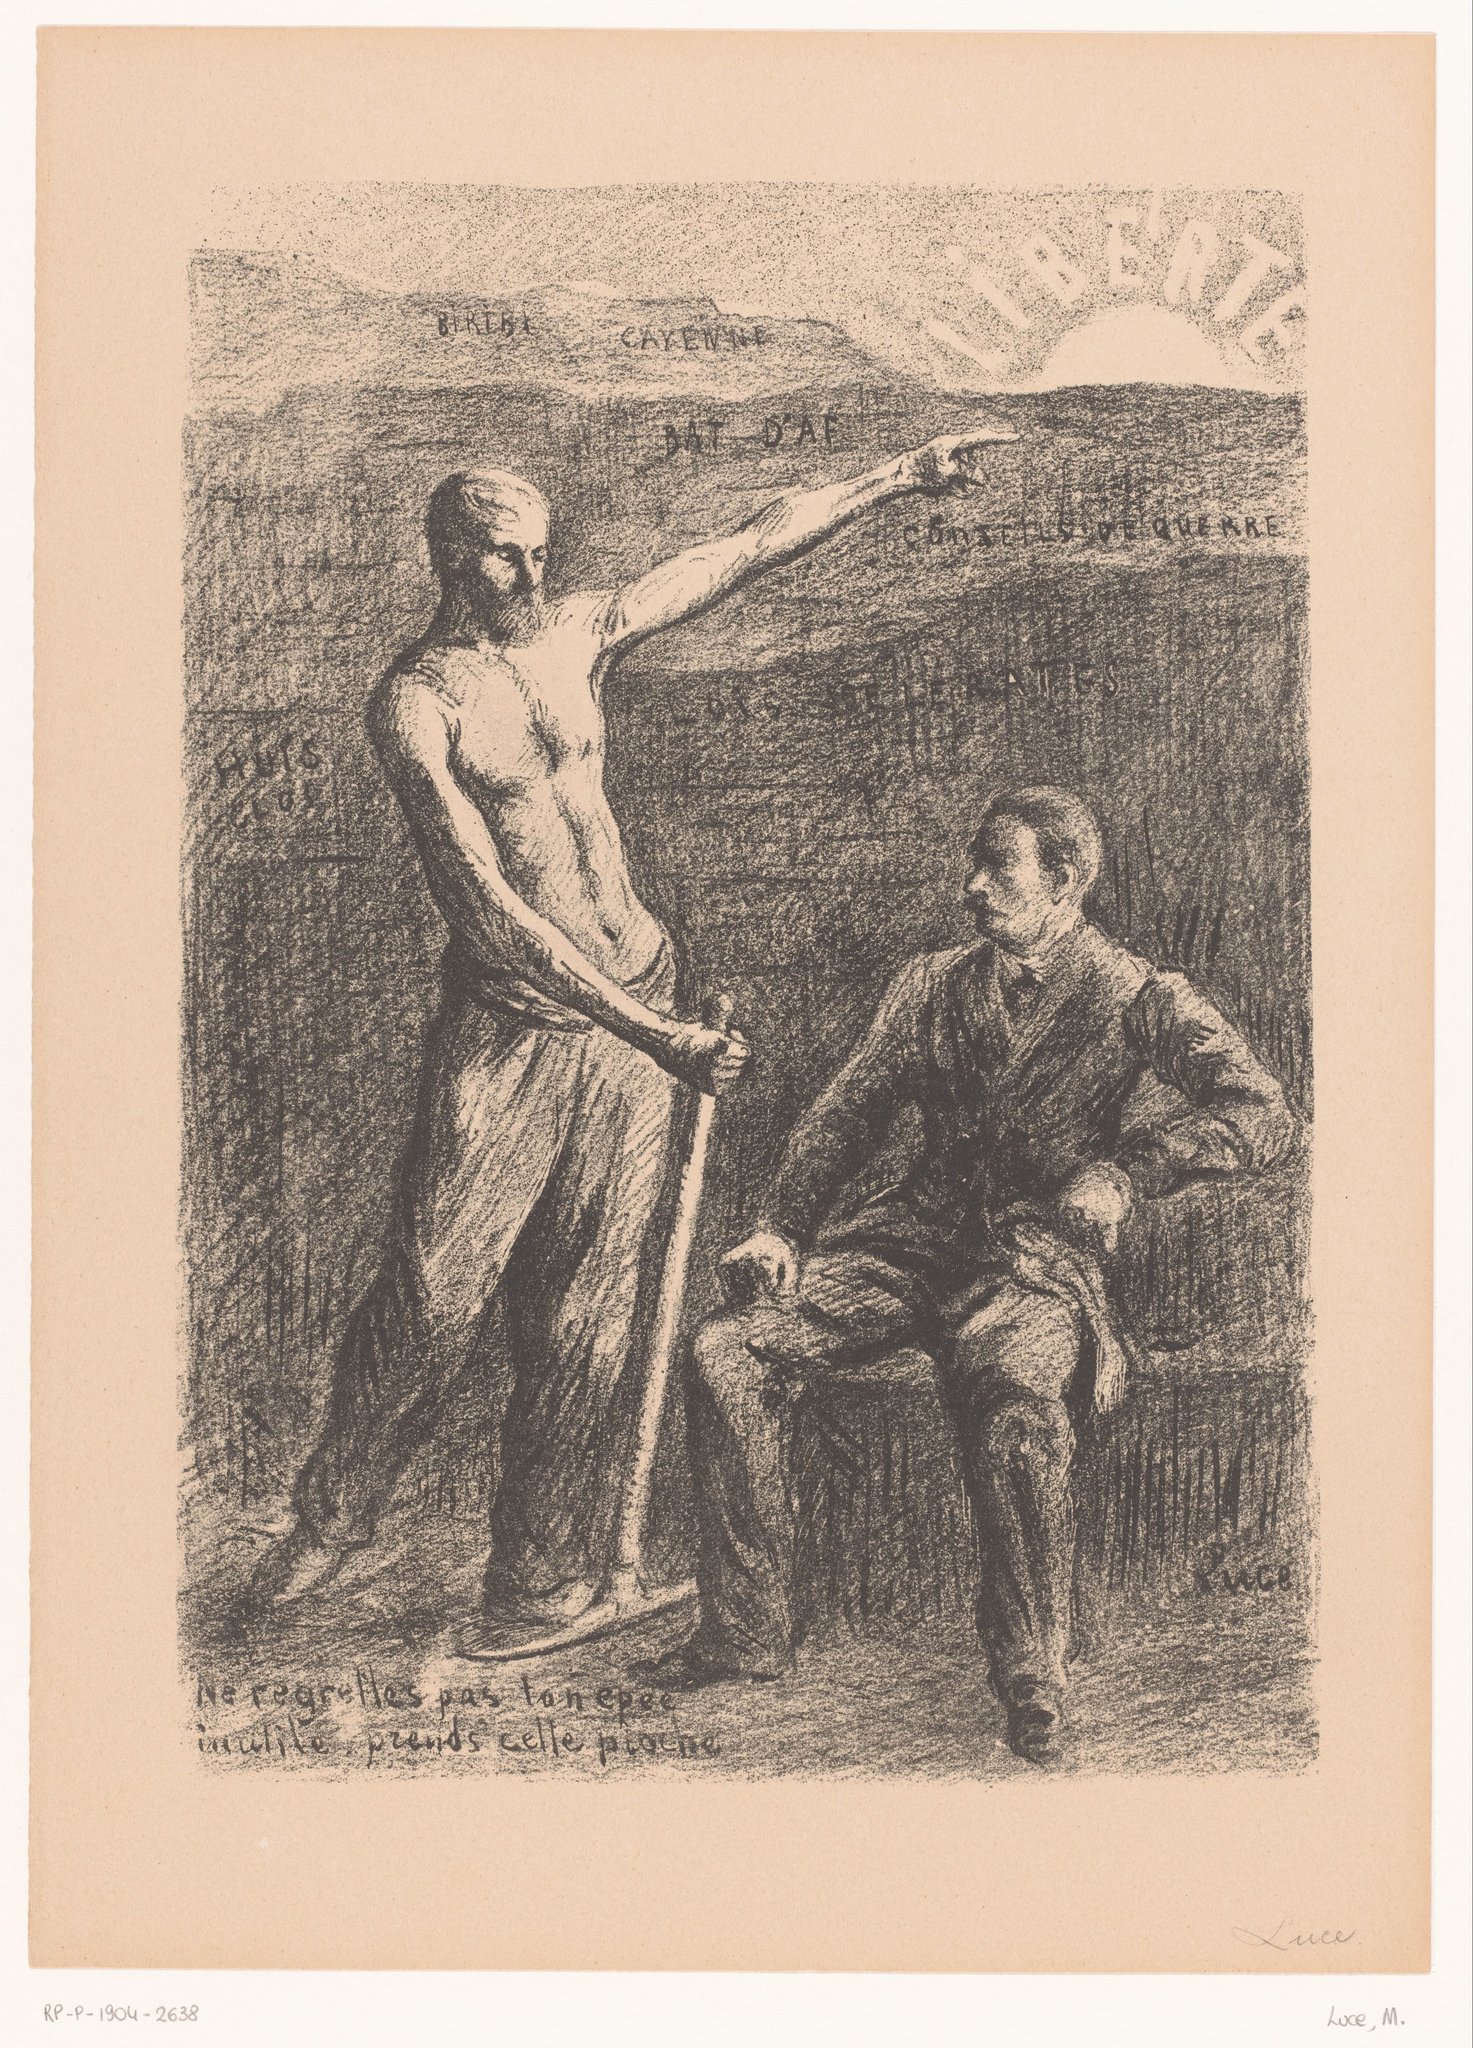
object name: print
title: Ne regrettes pas ton epee inutile, prends cette pioche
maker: maximilien luce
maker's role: print maker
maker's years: 1858-1941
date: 1899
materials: paper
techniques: lithograph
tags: tools, aids, implements ~ crafts and industries, standing figure, sitting figure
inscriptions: collector's mark: Lugt 2228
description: Prent uit: Hommage des artistes a Picquart. Album de 12 lithographies. Parijs: Société libre d'édition des gens de lettres, 1899. Onder supervisie van Félix Thureau en Paul Brenet uitgegeven als protest tegen de gevangenneming van kolonel Georges Picquart na zijn ontdekkingen met betrekking tot de Dreyfusaffaire. Met voorwoord van Octave Mirabeau en uitleg over de namenlijst door Henri Rainaldy.